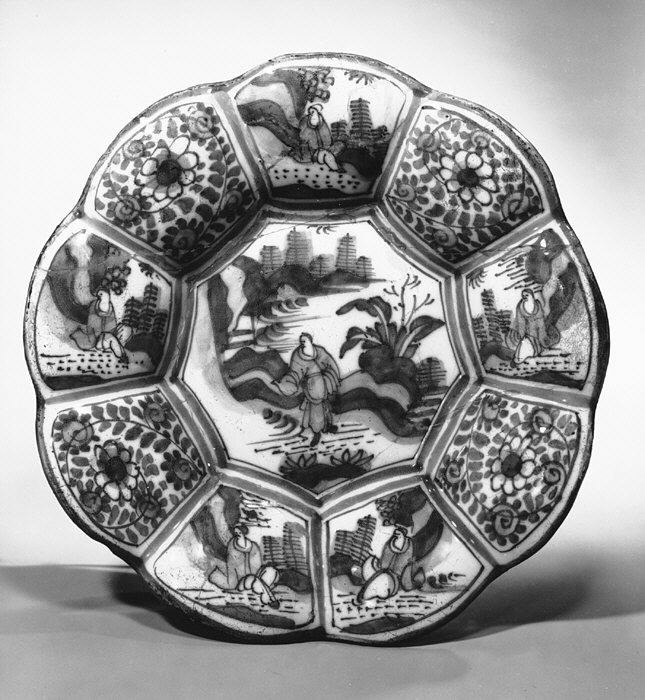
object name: dish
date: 1601-1700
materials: earthenware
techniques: glazing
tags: men,flowers